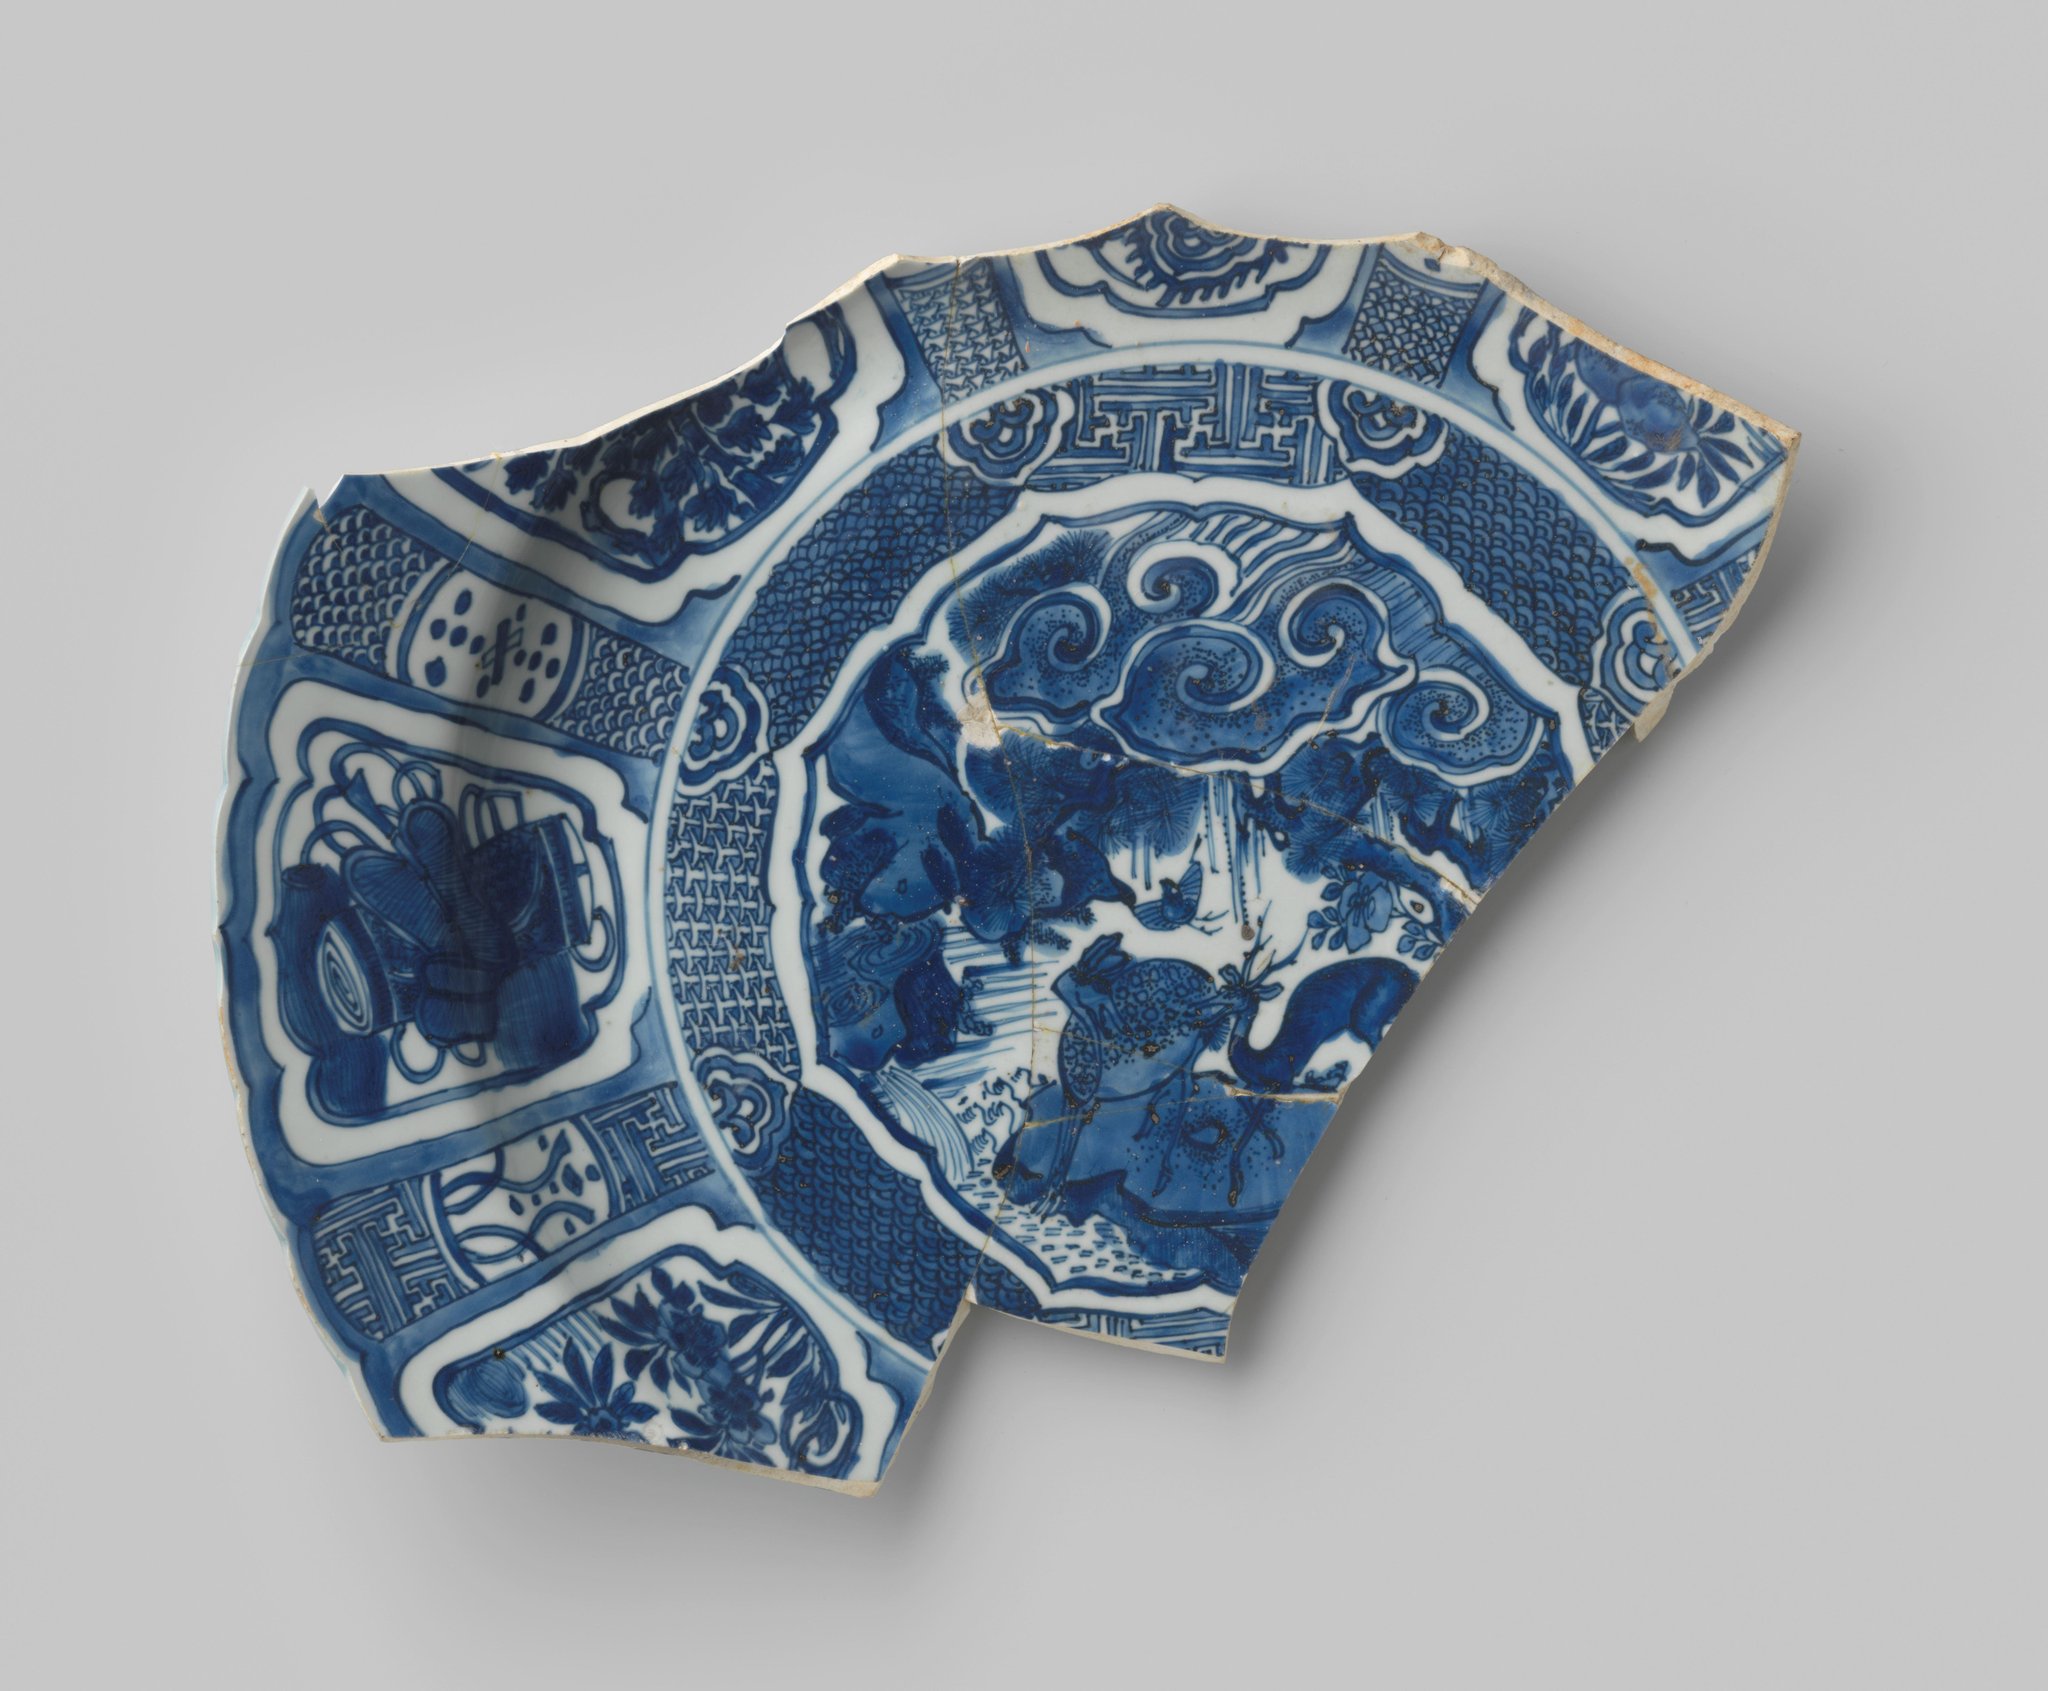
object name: washbowl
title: Fragment lampetschotel uit V.O.C.-schip de 'Witte Leeuw'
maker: Anonymous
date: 1613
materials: bone china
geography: jingdezhen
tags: verenigde oostindische compagnie, sint-helena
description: A large plate with a flattened rim. A scalloped medallion with rui heads within concentric bands filled with alternating diaper patterns.